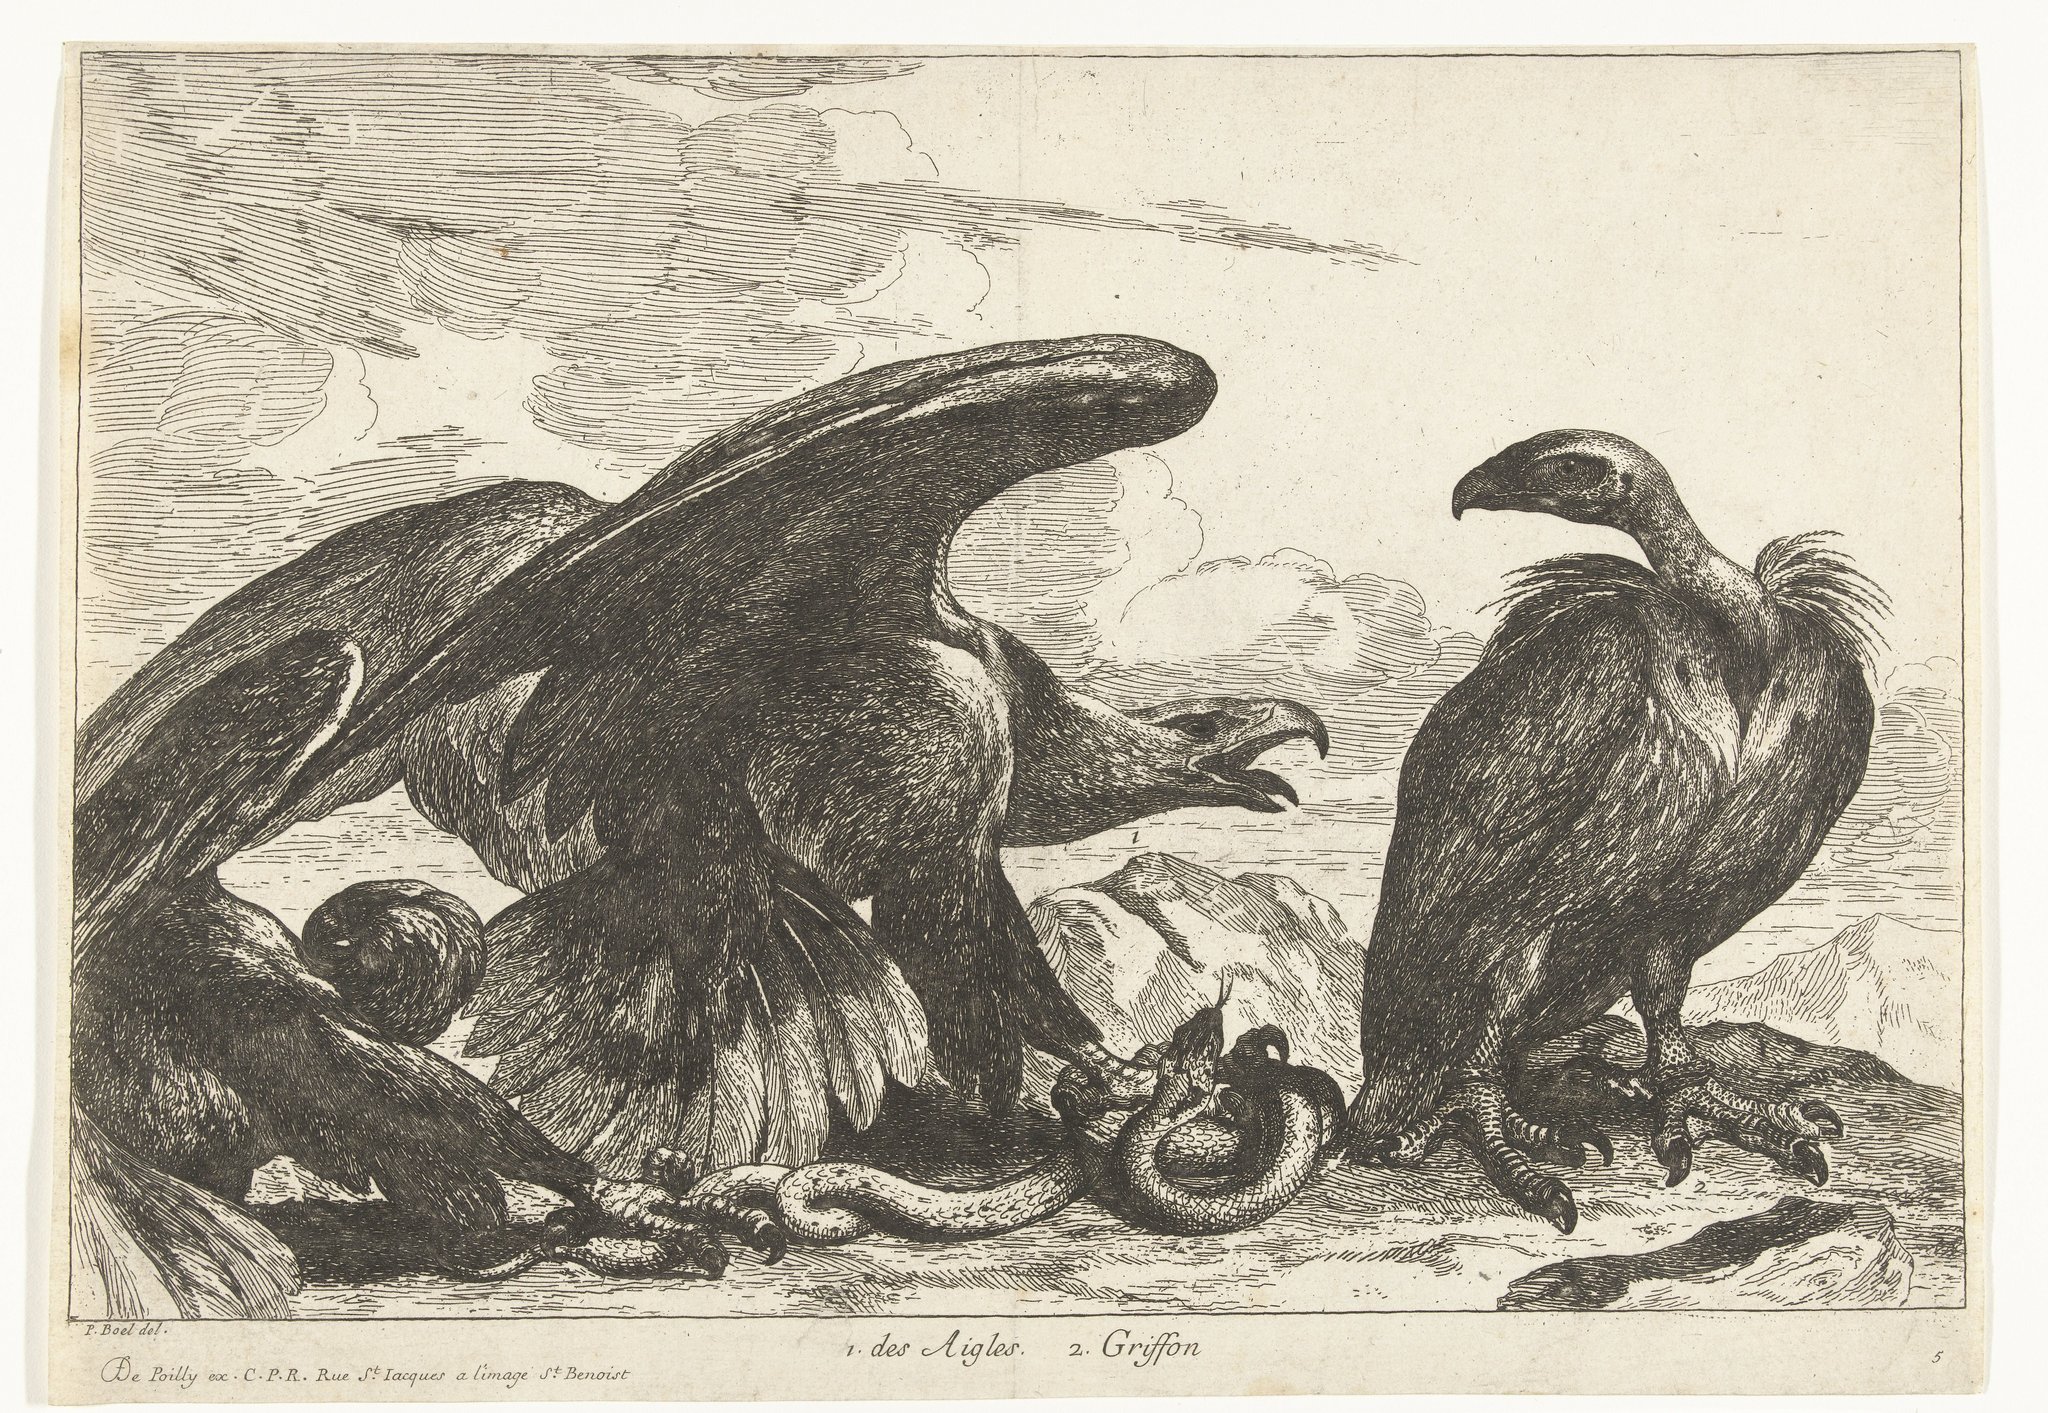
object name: print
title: Vogels uit de menagerie van Versailles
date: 1670-1674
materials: paper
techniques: etching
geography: paris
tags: predatory birds: eagle, predatory birds: vulture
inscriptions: collector's mark: Lugt 2228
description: In een rotsachtig landschap vechten een arend en een gier om een slang.